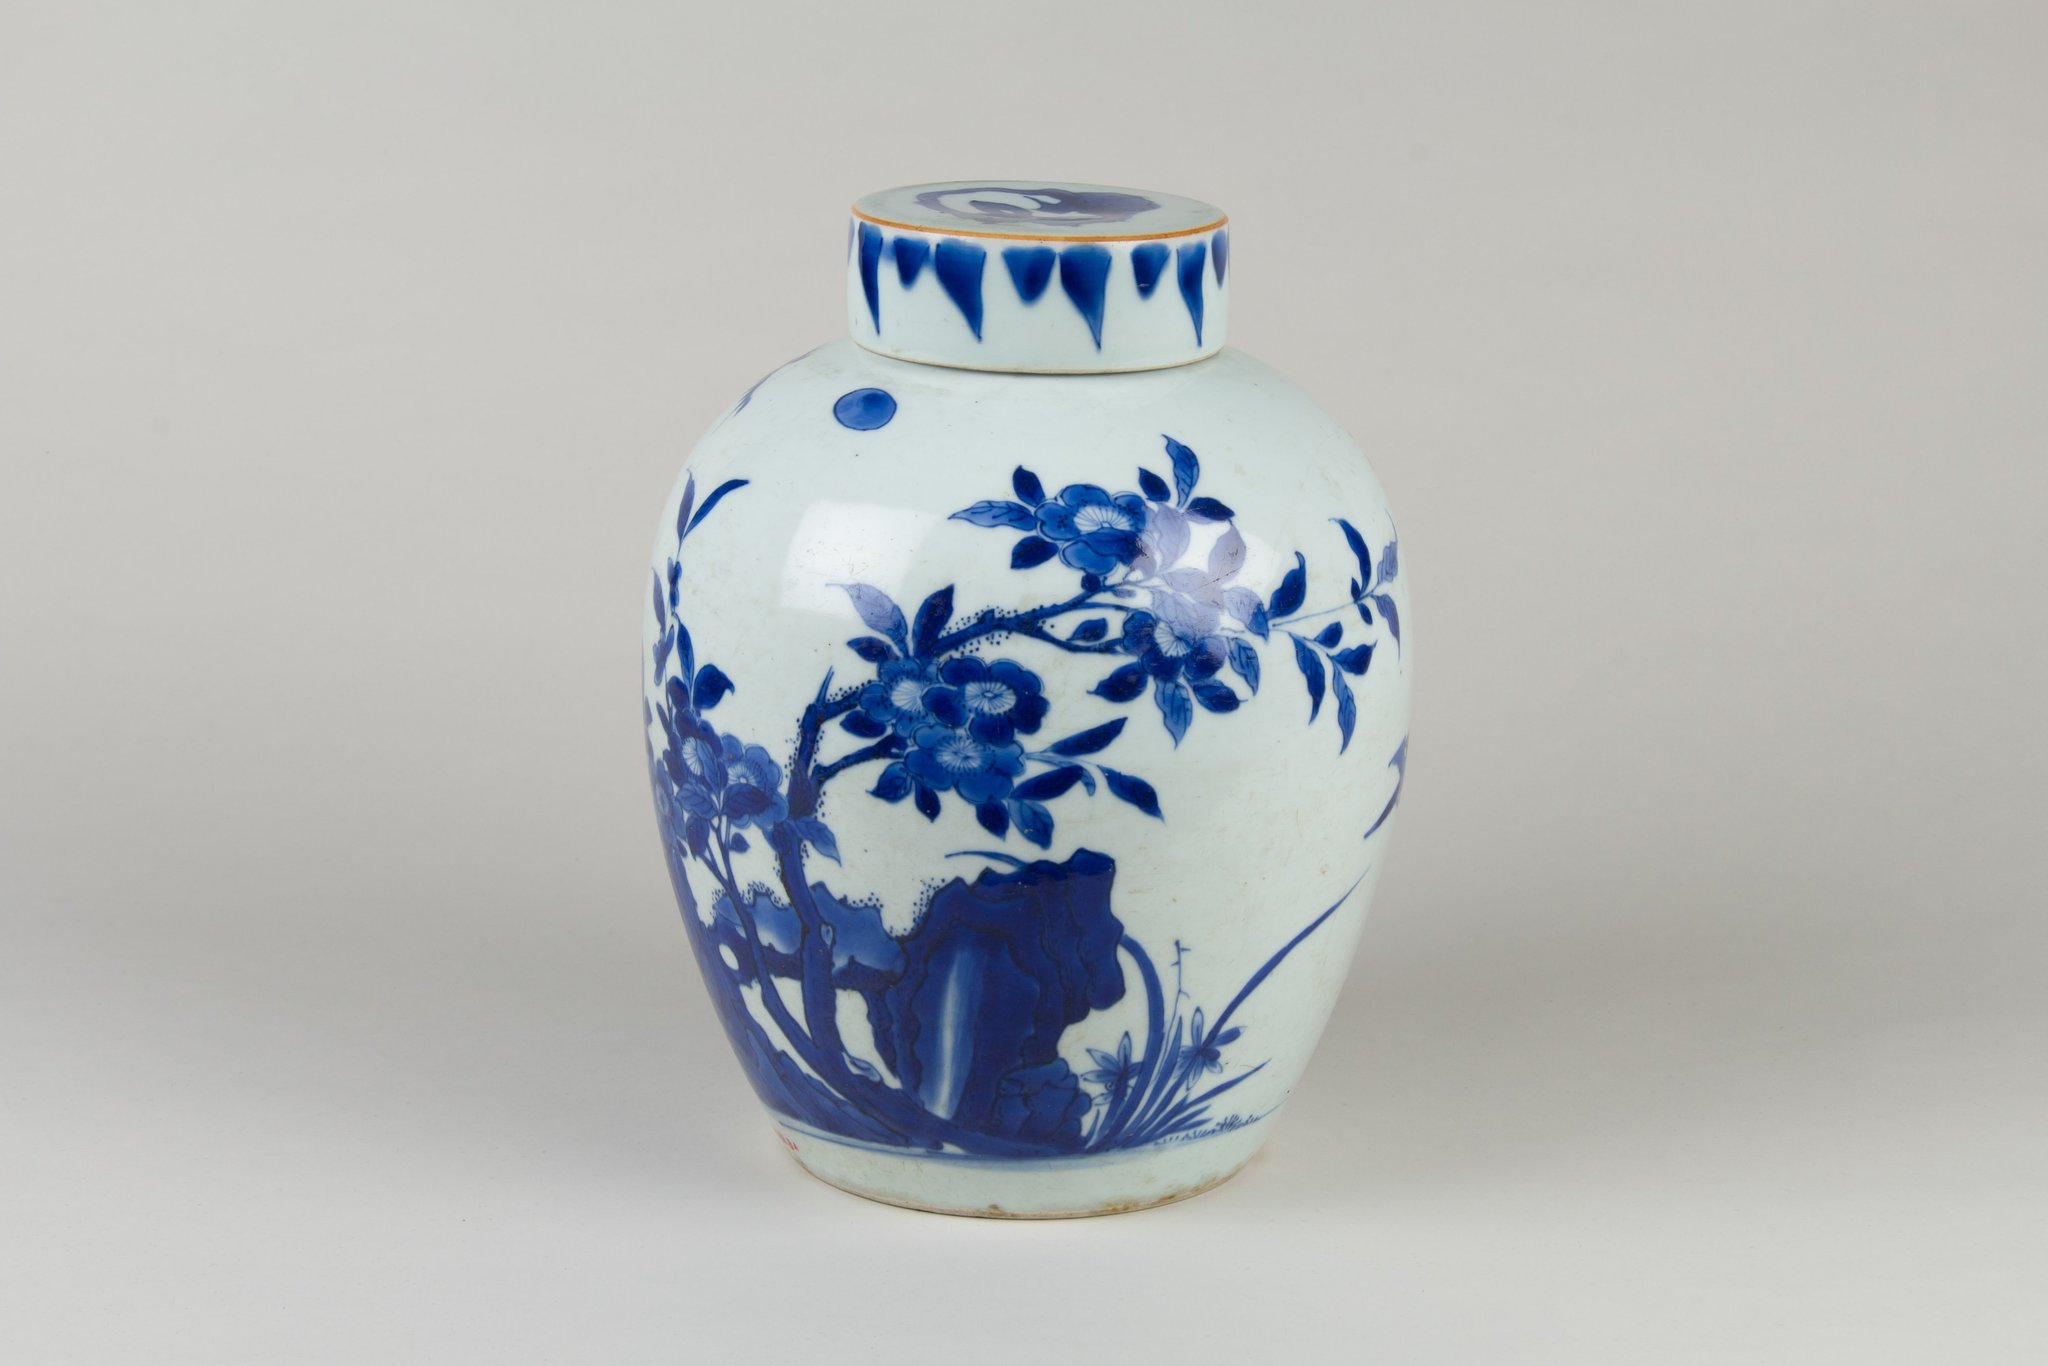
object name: covered jar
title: Covered jar with birds and flowers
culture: chinese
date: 1634-1666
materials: cobalt, porcelain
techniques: painting, underglaze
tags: birds,flowers